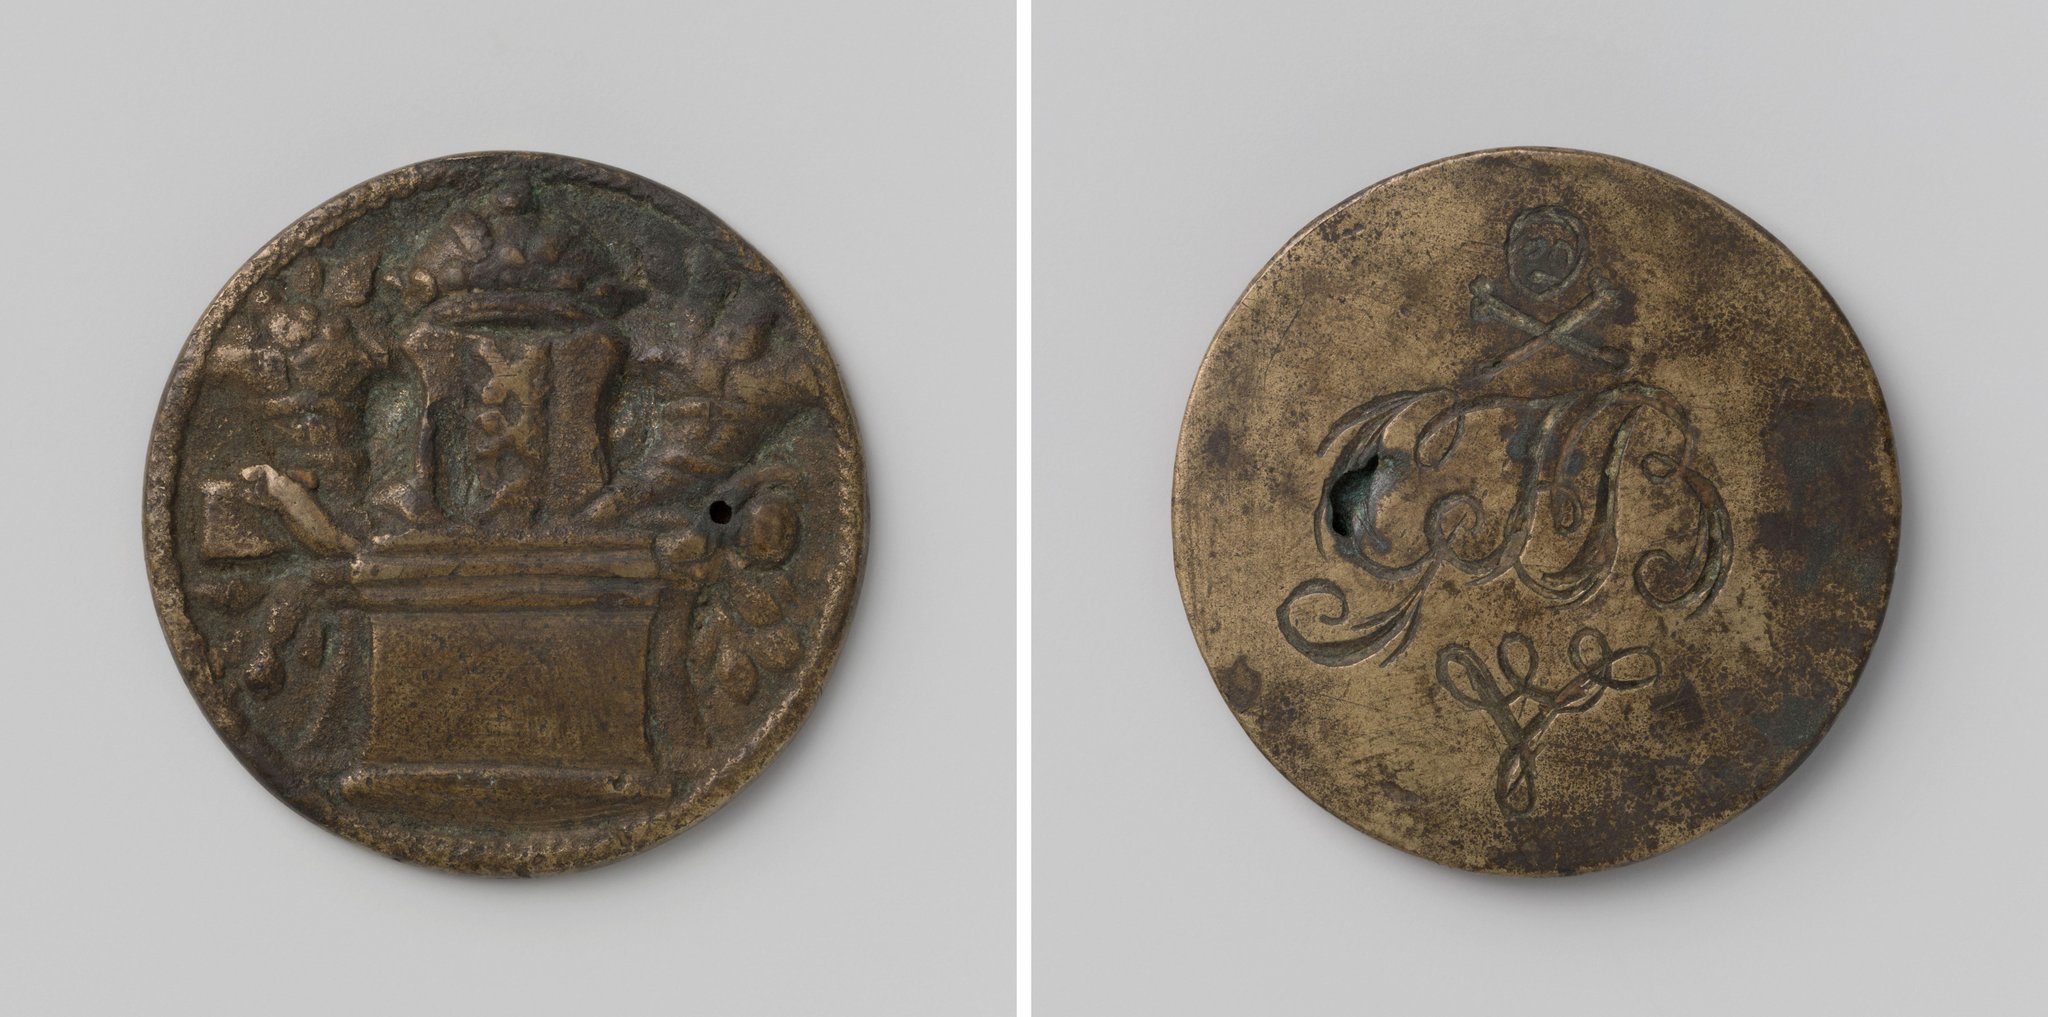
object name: medal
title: Collegium Medicum te Amsterdam, toegangspenning voor de hortus medicus voor leerling G.J.B.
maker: Anonymous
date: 1700-1800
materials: brass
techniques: casting, engraving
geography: amsterdam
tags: hortus medicus, collegium medicum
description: Messing penning. Voorzijde: gekroond wapenschild tussen twee gevulde hoorns van overvloed boven zalfspatel, waarom slang zich kronkelt, liggend op voetstuk. Keerzijde: monogram G.J.B. onder doodshoofd met beenderen boven siermotief